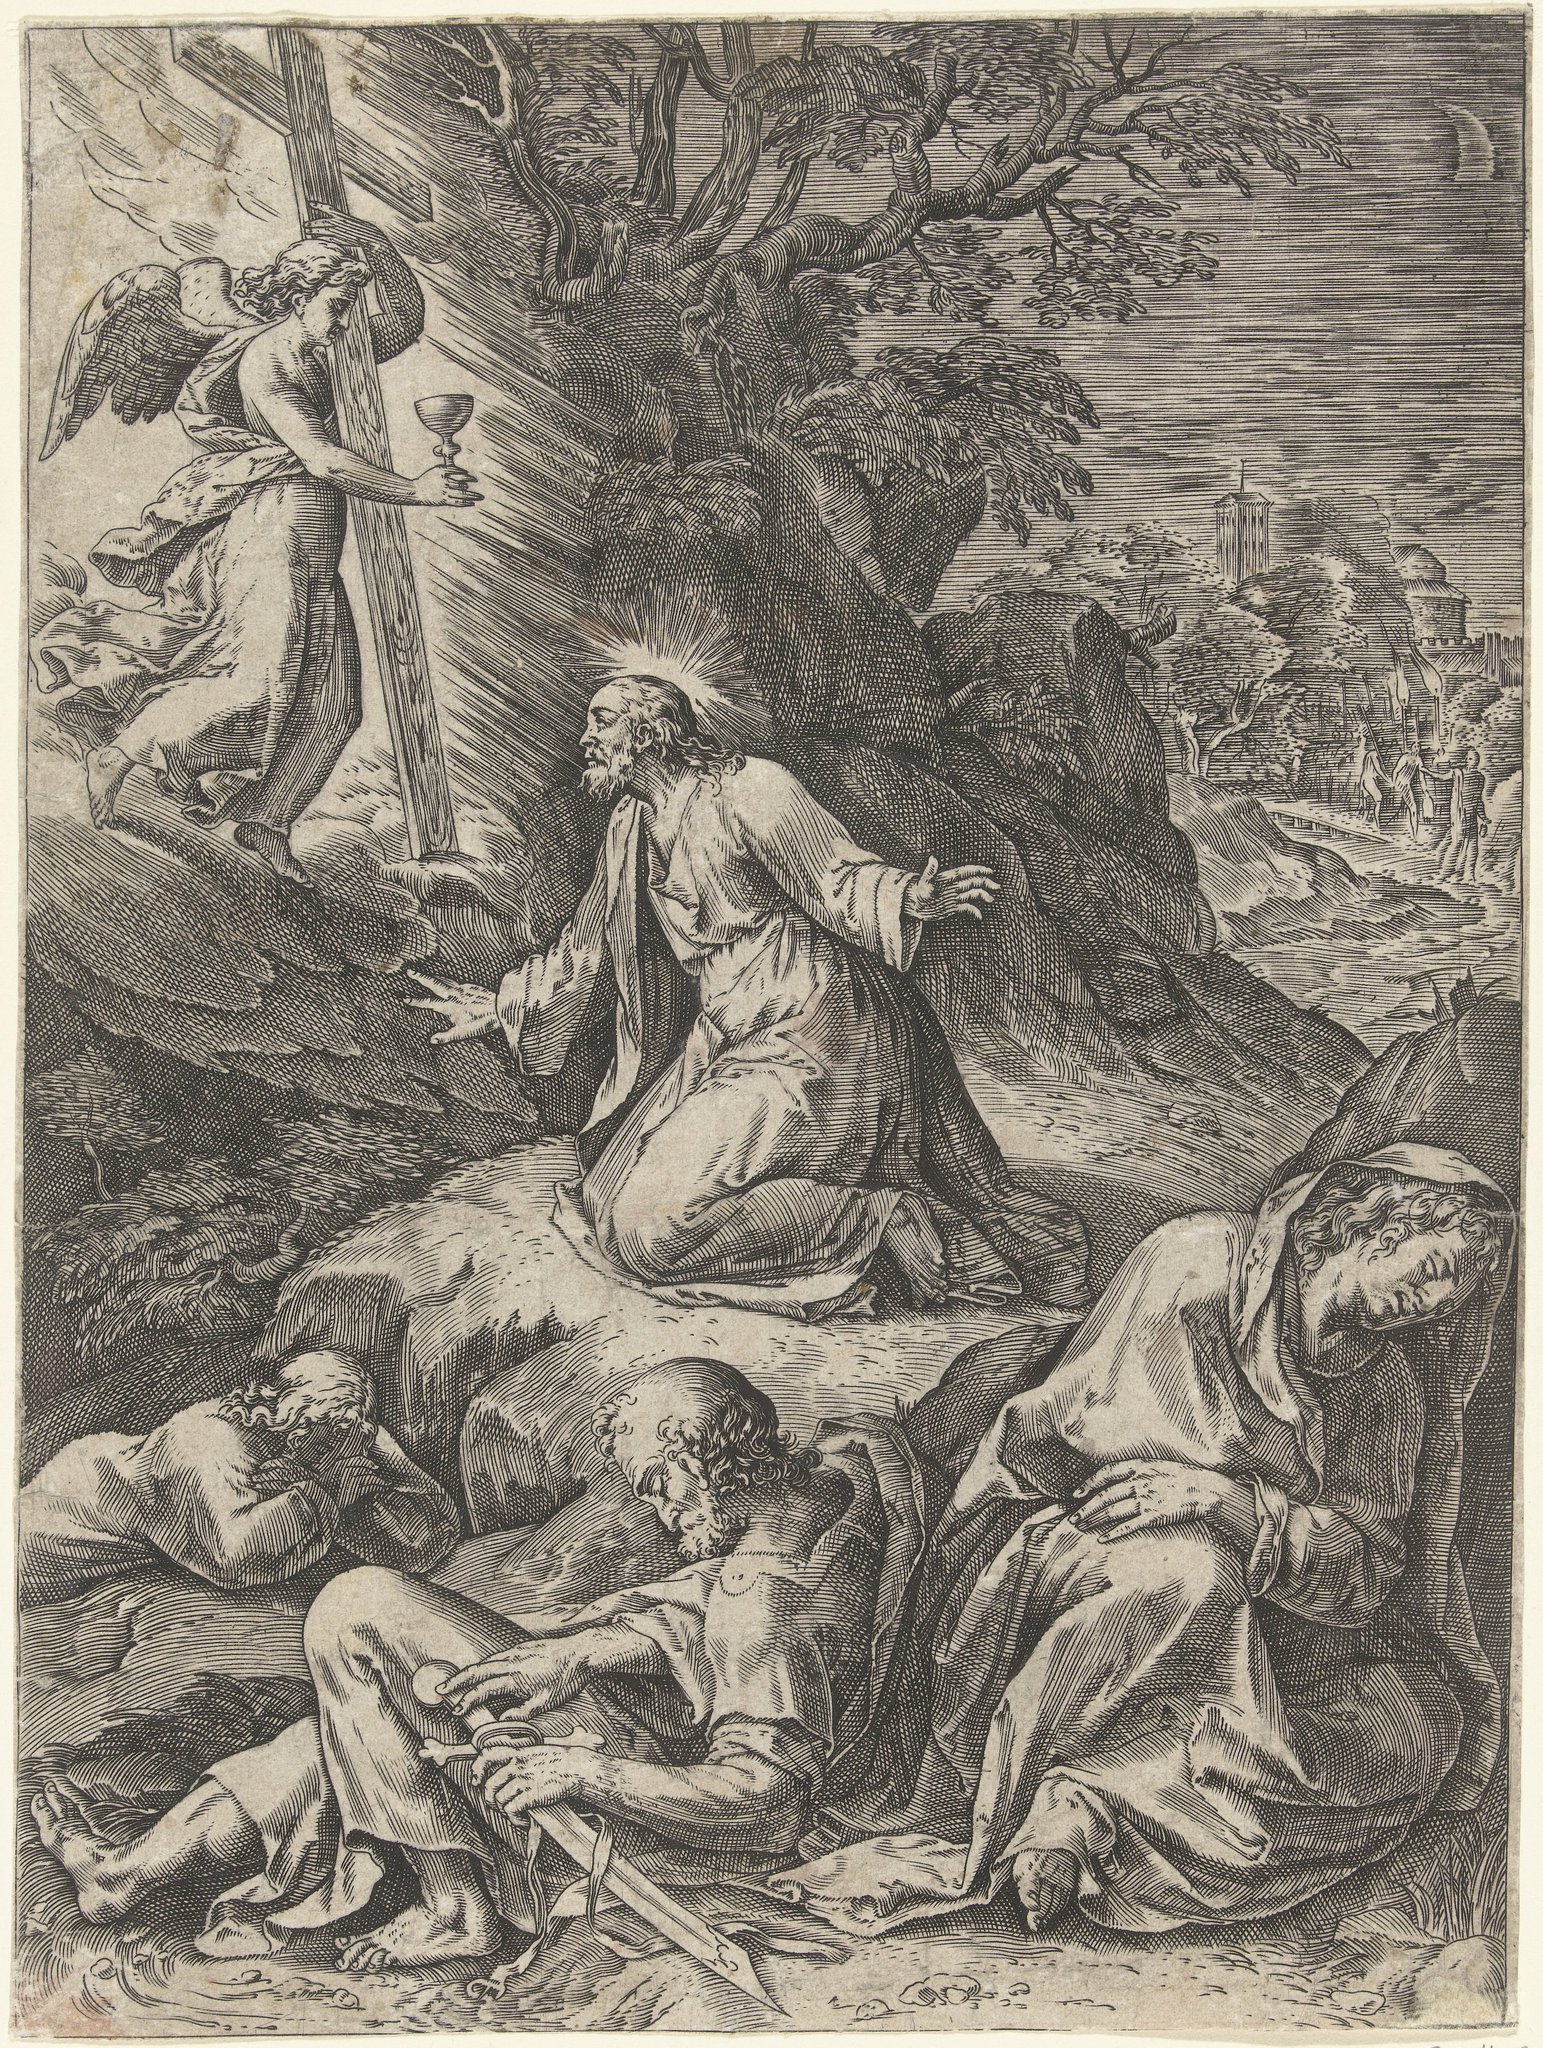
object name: print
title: Christus op de olijfberg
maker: Anonymous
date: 1569-1619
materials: paper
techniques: engraving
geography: rome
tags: agony of christ: to comfort him one or more angels appear to christ with chalice and/or cross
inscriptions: collector's mark: Lugt 2228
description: Christus bidt 's nachts op de olijfberg. Een engel verschijnt voor hem met een kruis en een kelk. Christus discipelen zijn in slaap gevallen. Op de achtergrond is een stoet soldaten met fakkels te zien die op zoek zijn naar Christus om hem gevangen te nemen.